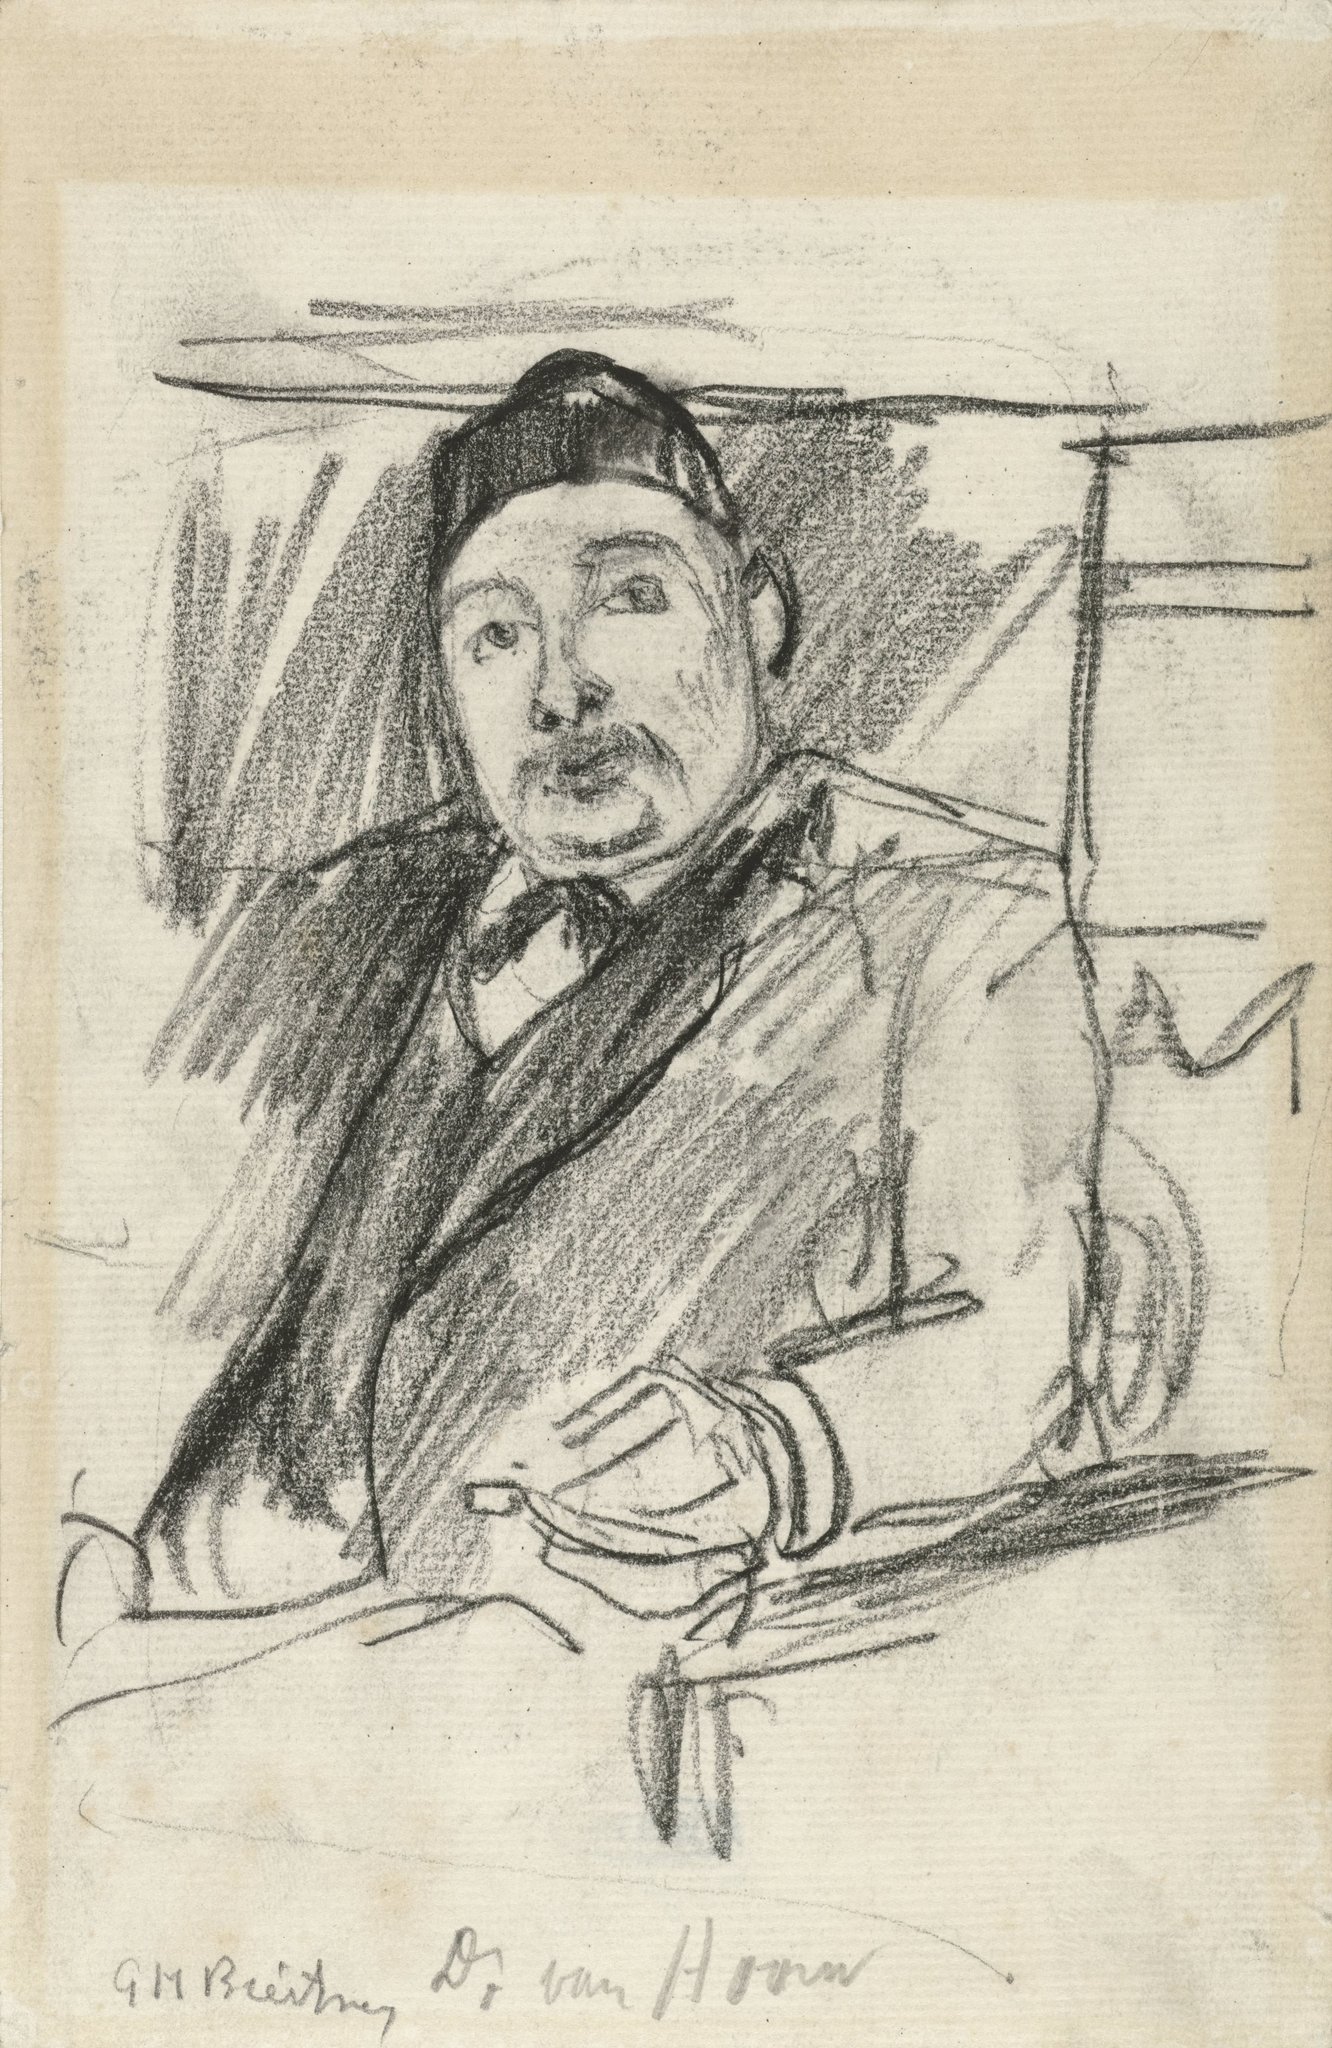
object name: drawing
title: Portret van Dr. van Hoorn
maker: george hendrik breitner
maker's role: draughtsman, painter, print maker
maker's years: 1857-1923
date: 1867-1923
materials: chalk, paper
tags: historical persons